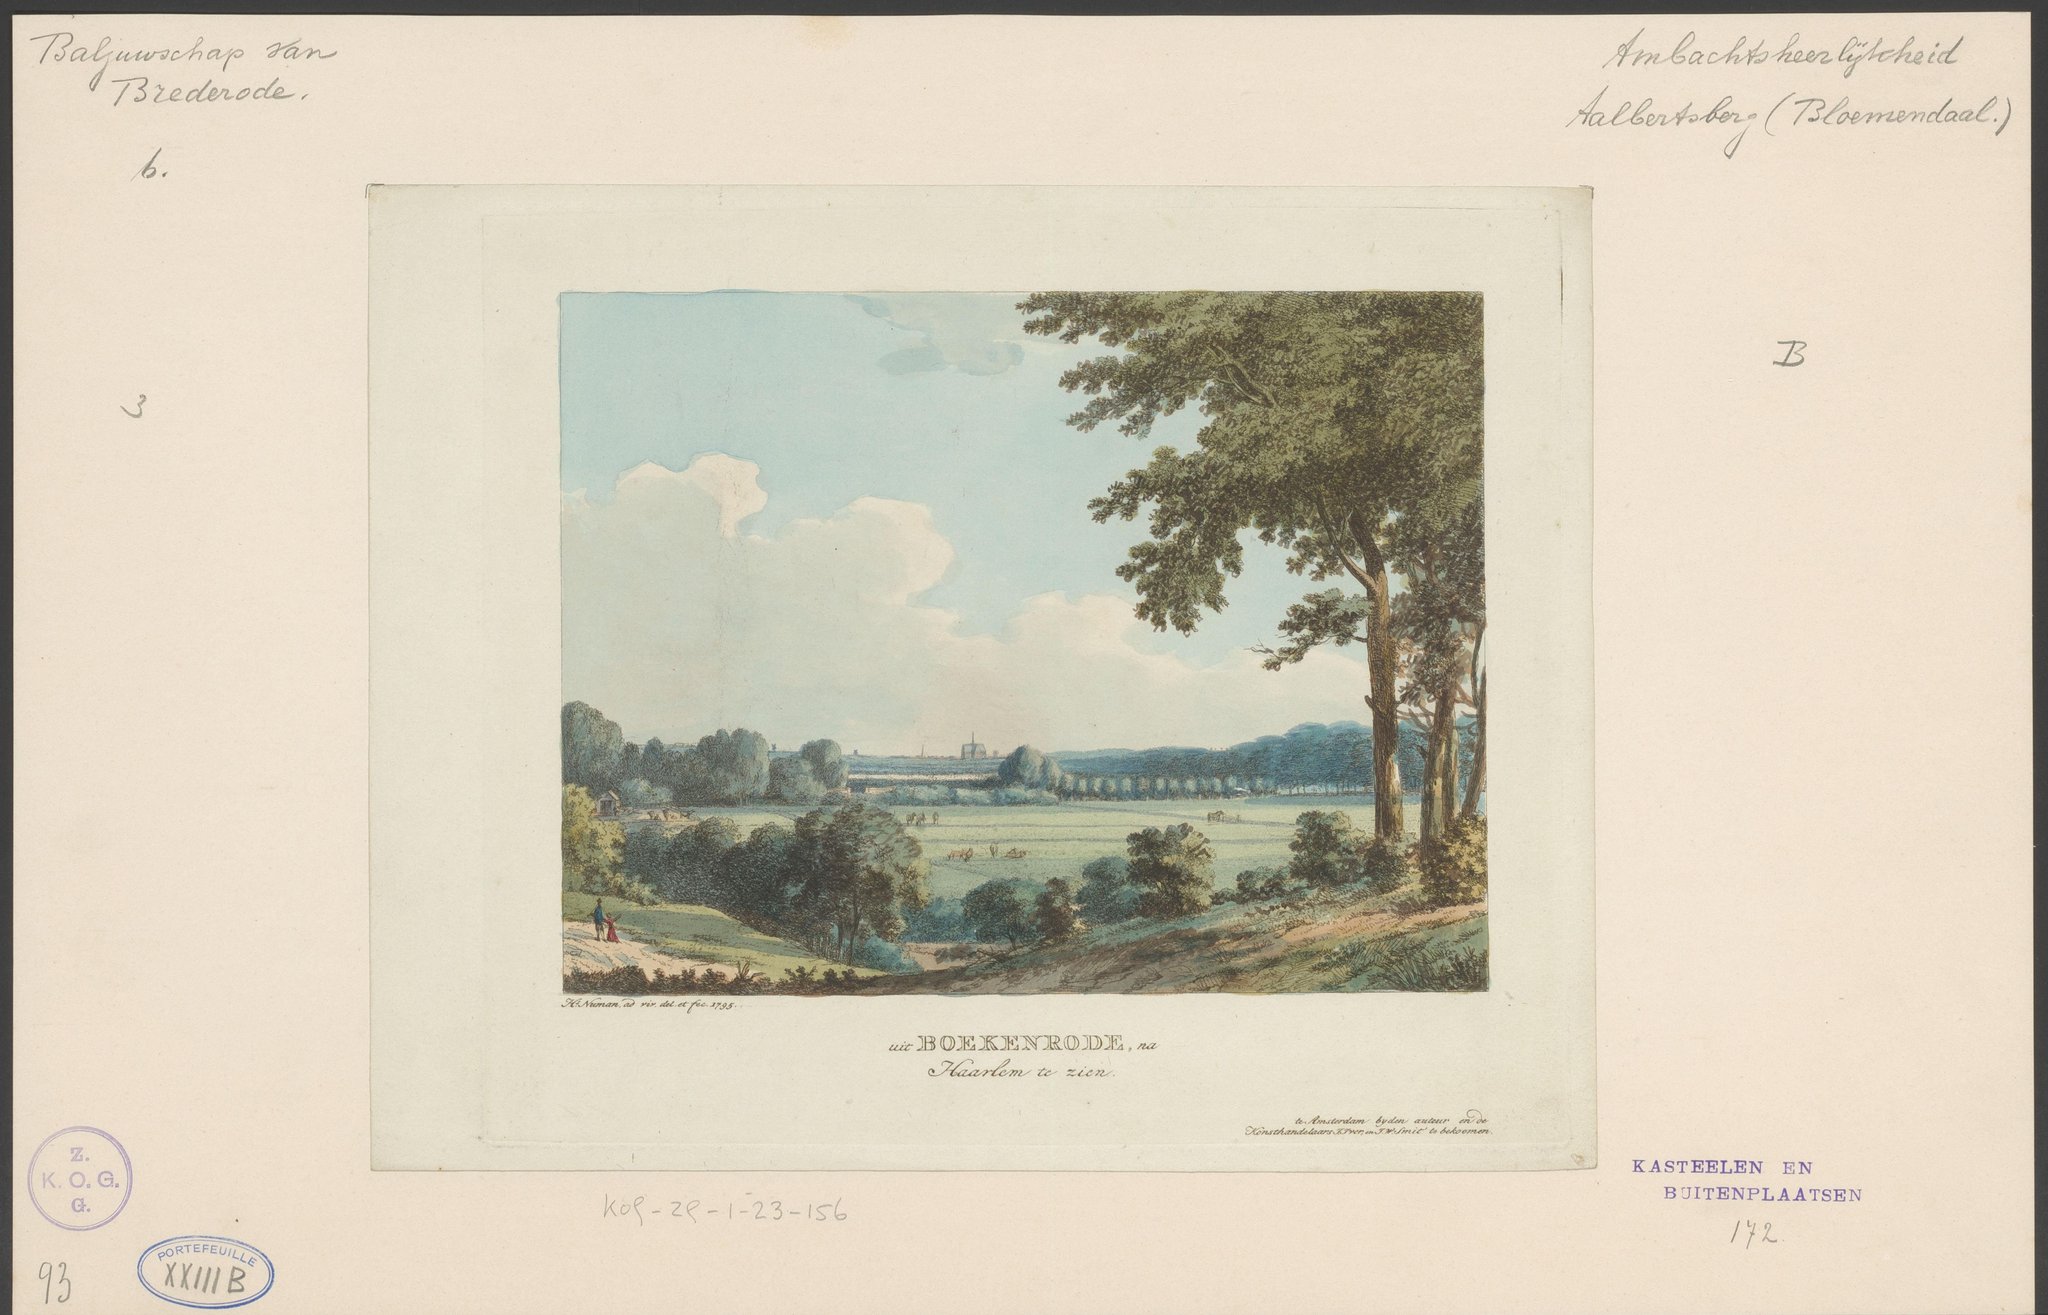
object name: print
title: Gezicht op Buitenplaats Boekenrode te Aerdenhout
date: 1795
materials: paper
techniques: engraving, etching, hand coloring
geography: amsterdam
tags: country-house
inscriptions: stamp, collector's mark: Lugt 1641, stamp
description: Prent gebruikt in: Numan, Hermanus. Vierentwintig printtekeningen met couleuren, verbeeldende Hollandsche buitenplaatzen. Amsterdam: Jan IJver, Jan Willem Smit en Hermanus Numan, 1797.